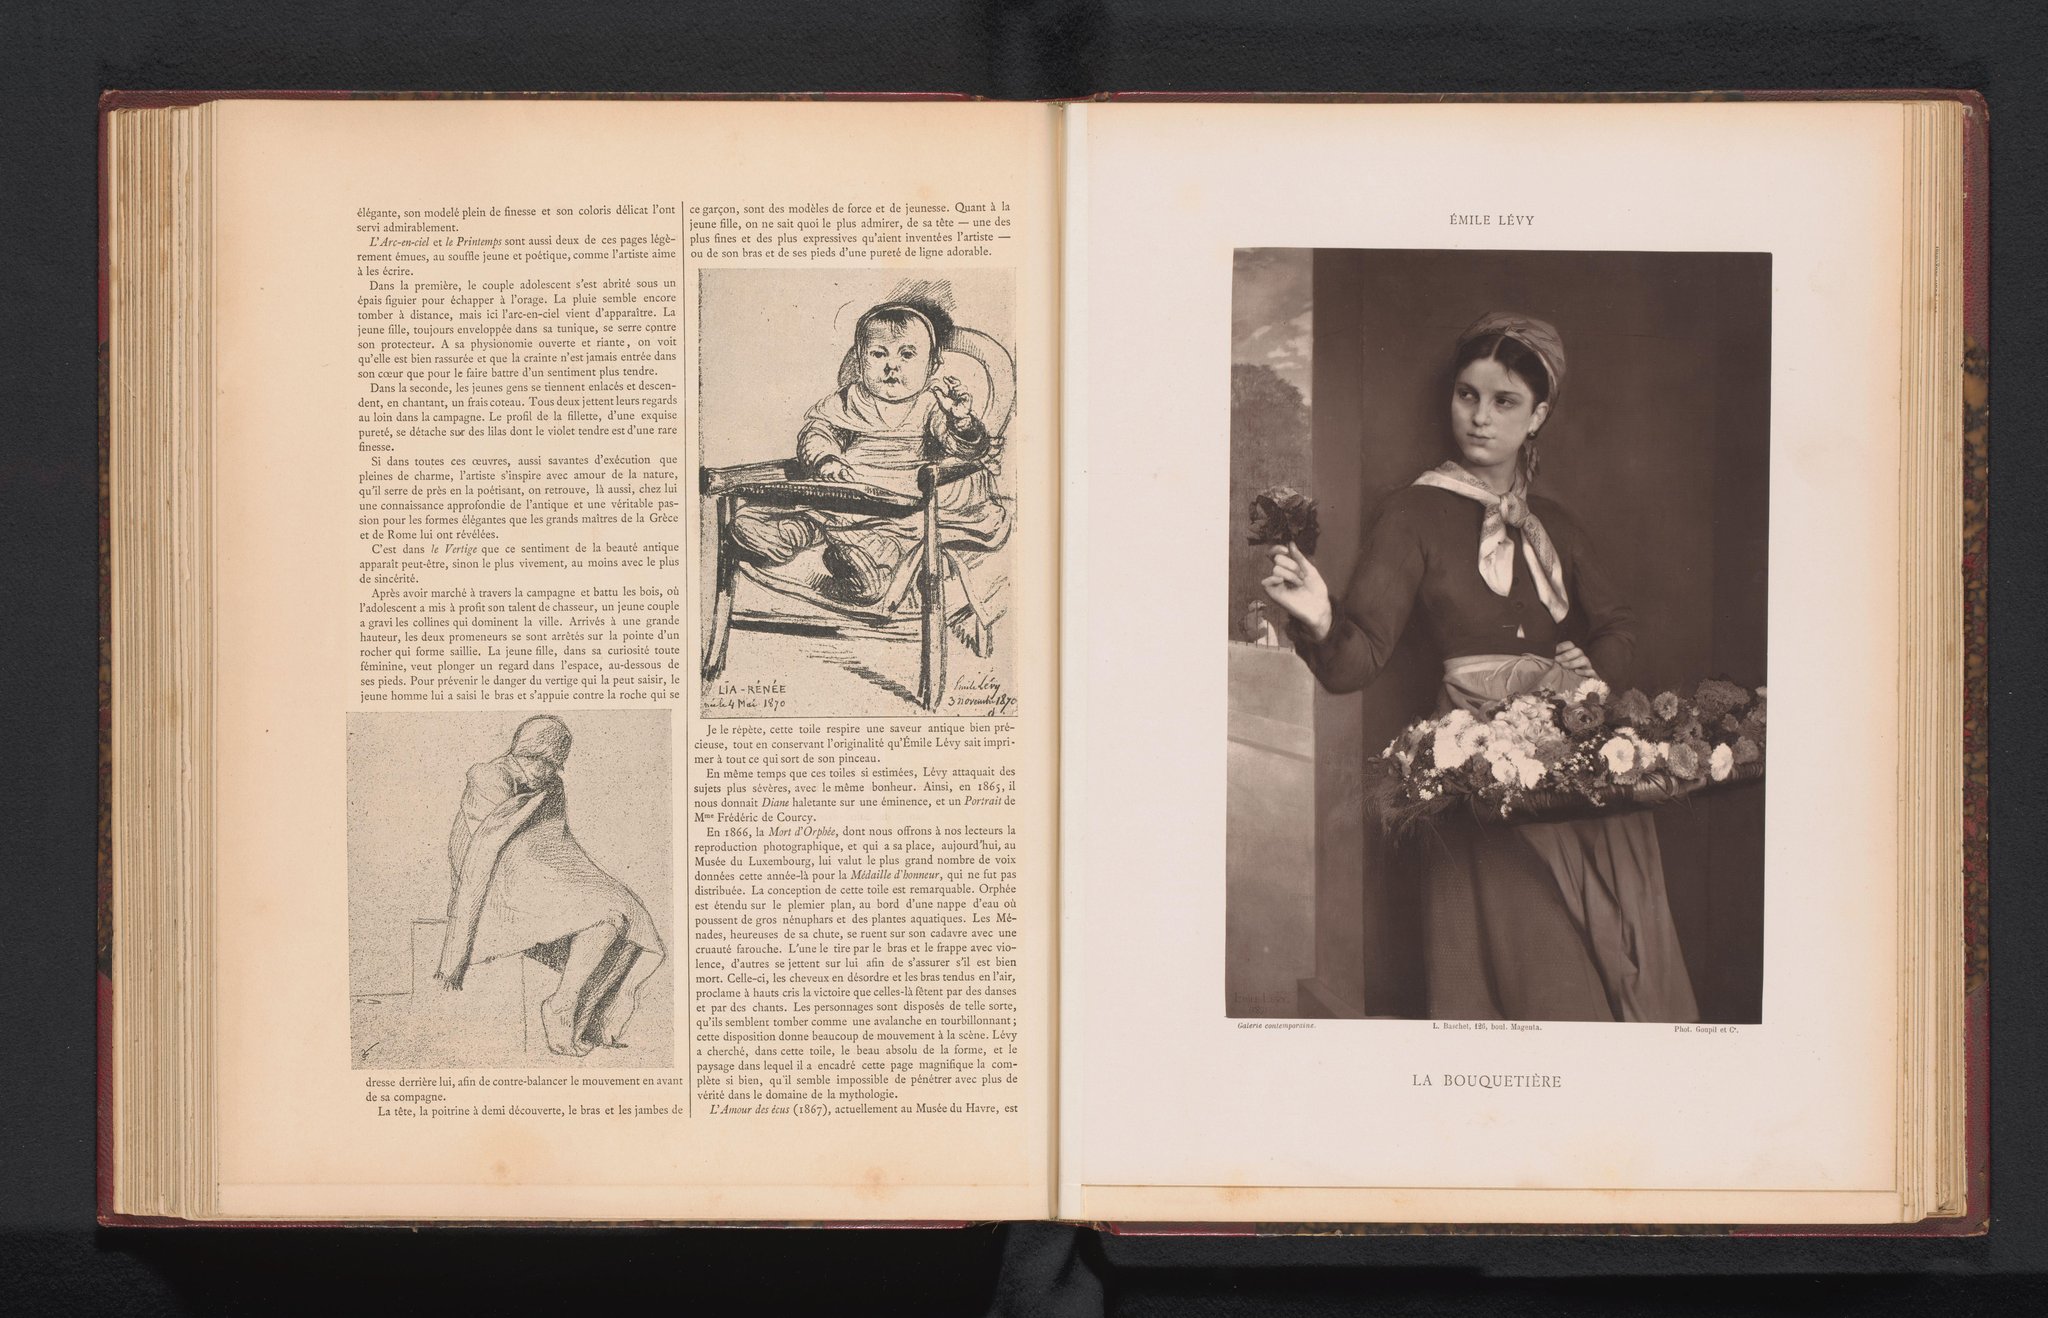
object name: photomechanical print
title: Reproductie van La bouquetière door Émile Lévy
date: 1873-1878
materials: paper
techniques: woodburytype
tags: flowers, adolescent, young woman, maiden, painting, drawing and the graphic arts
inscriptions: inscription: ‘Galerie Contemporaine/ L. Basschet, 126, boul. Magenta.’